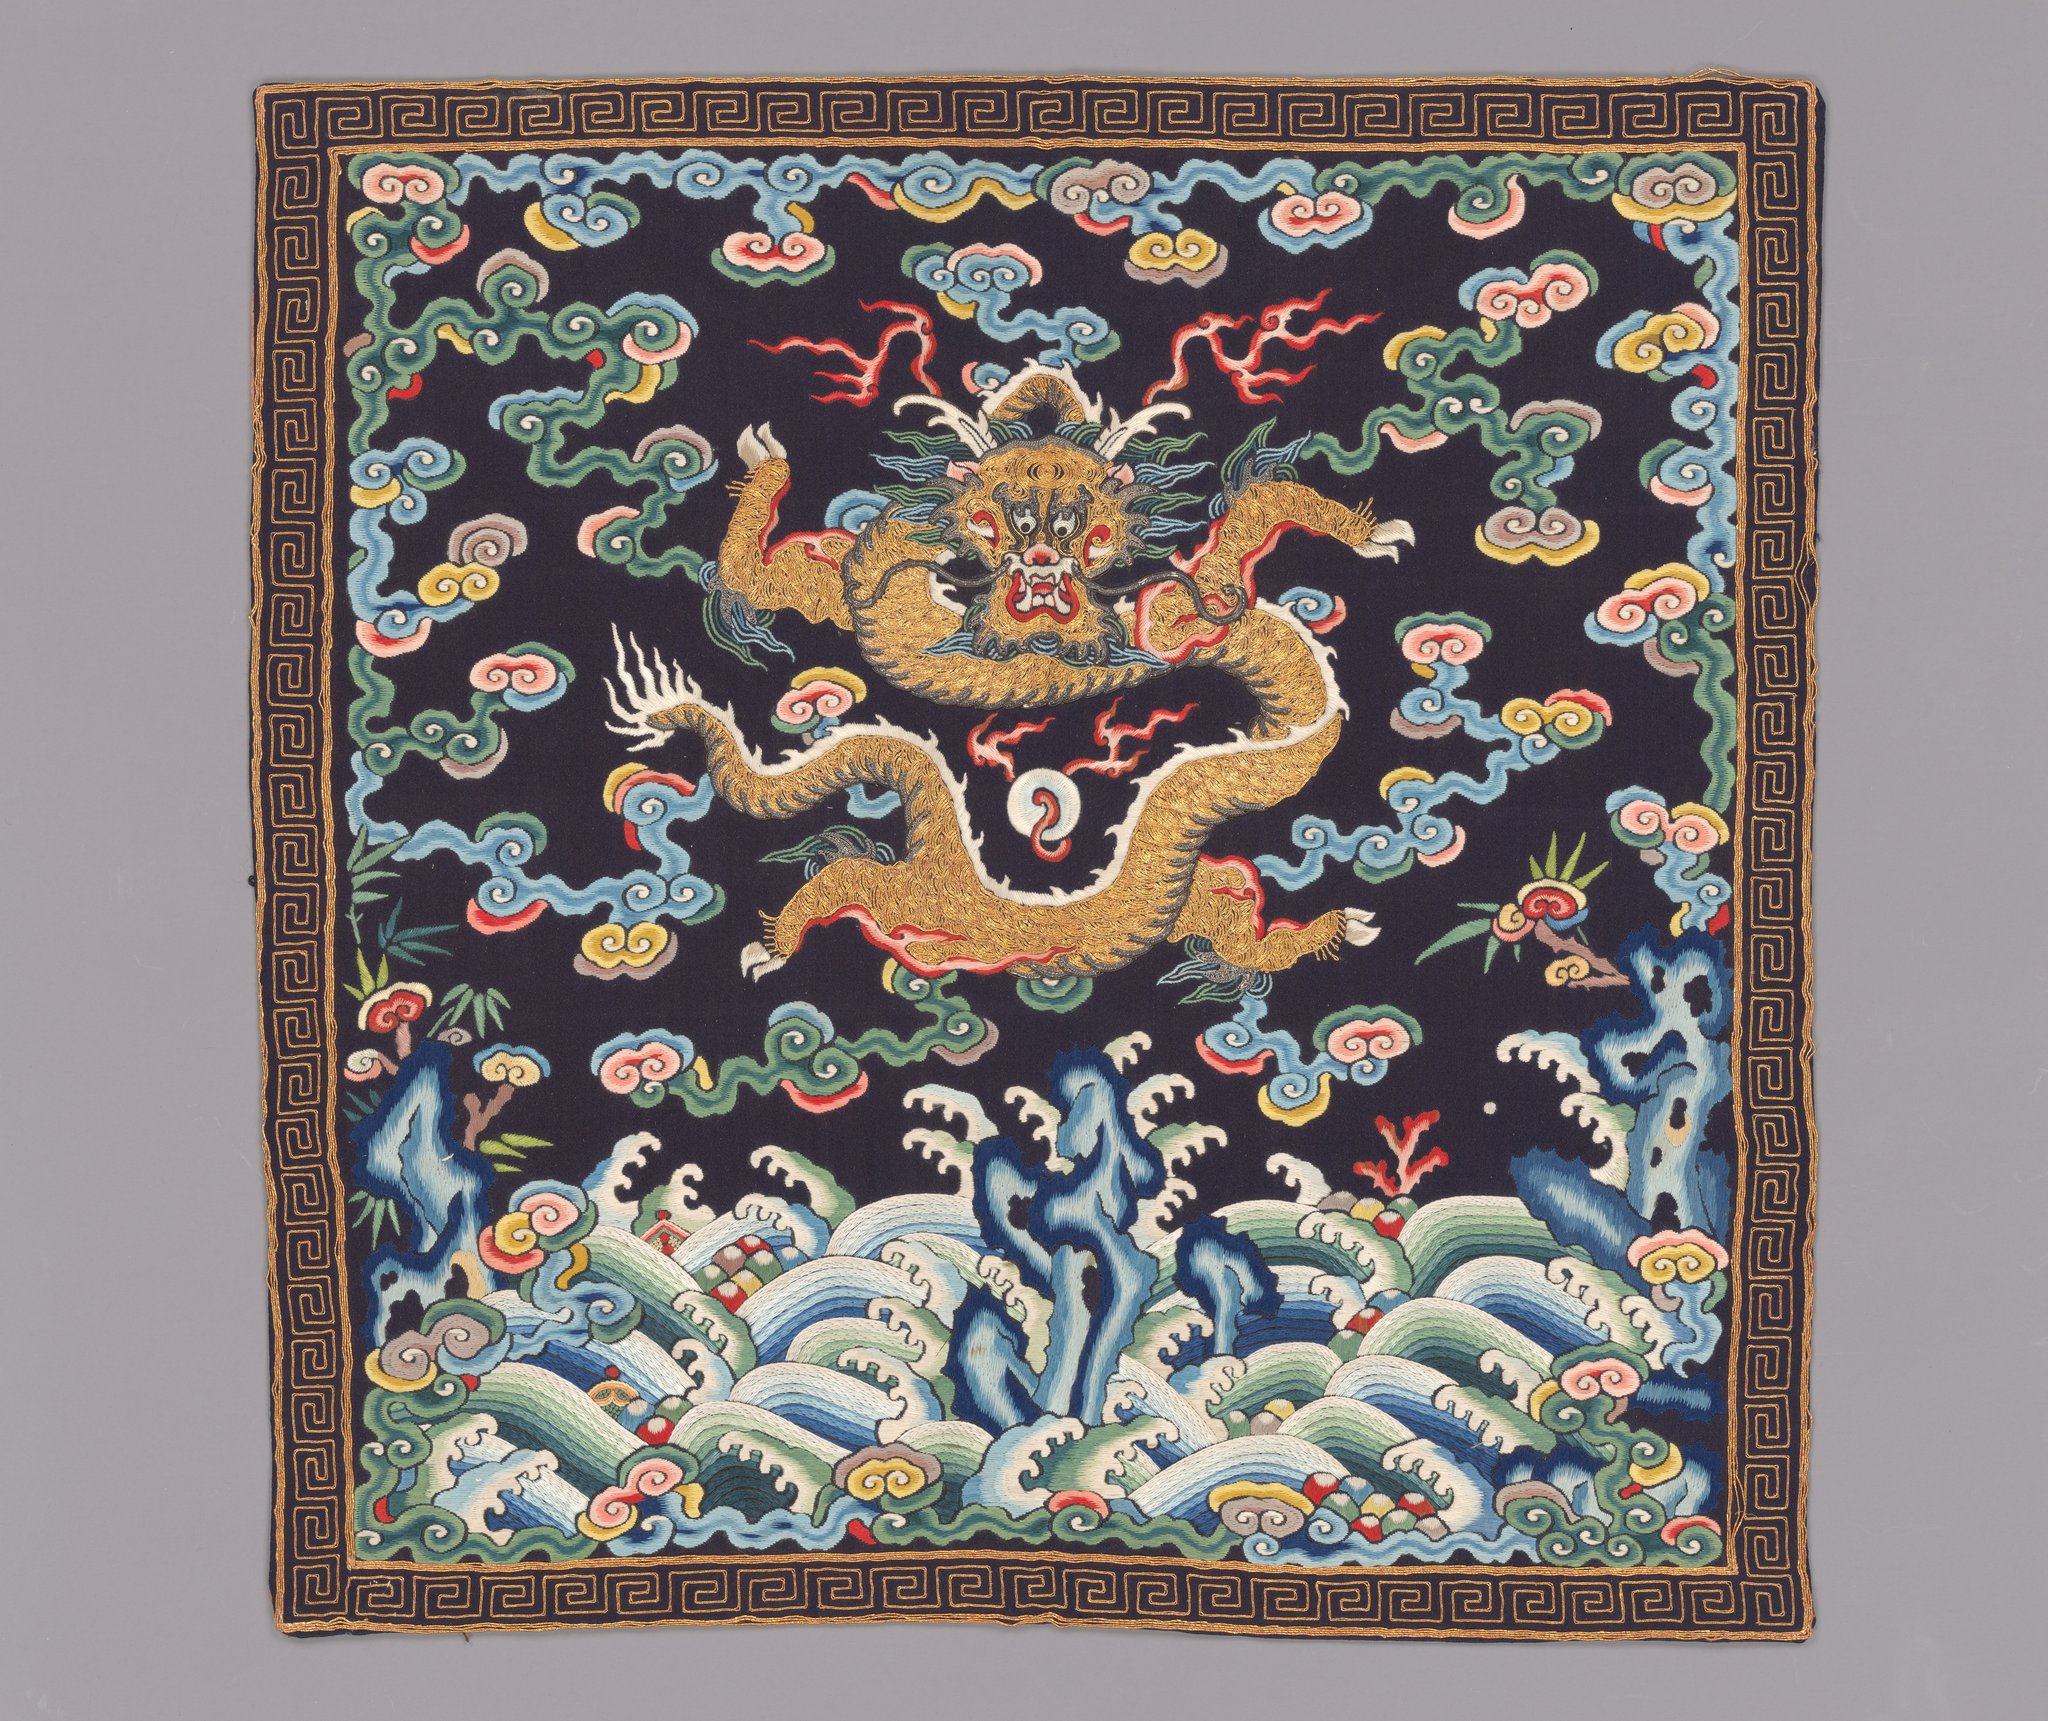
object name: rank badge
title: Rank Badge with Dragon with Deer Hooves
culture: chinese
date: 1701-1900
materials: metal thread, silk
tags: dragons,badges